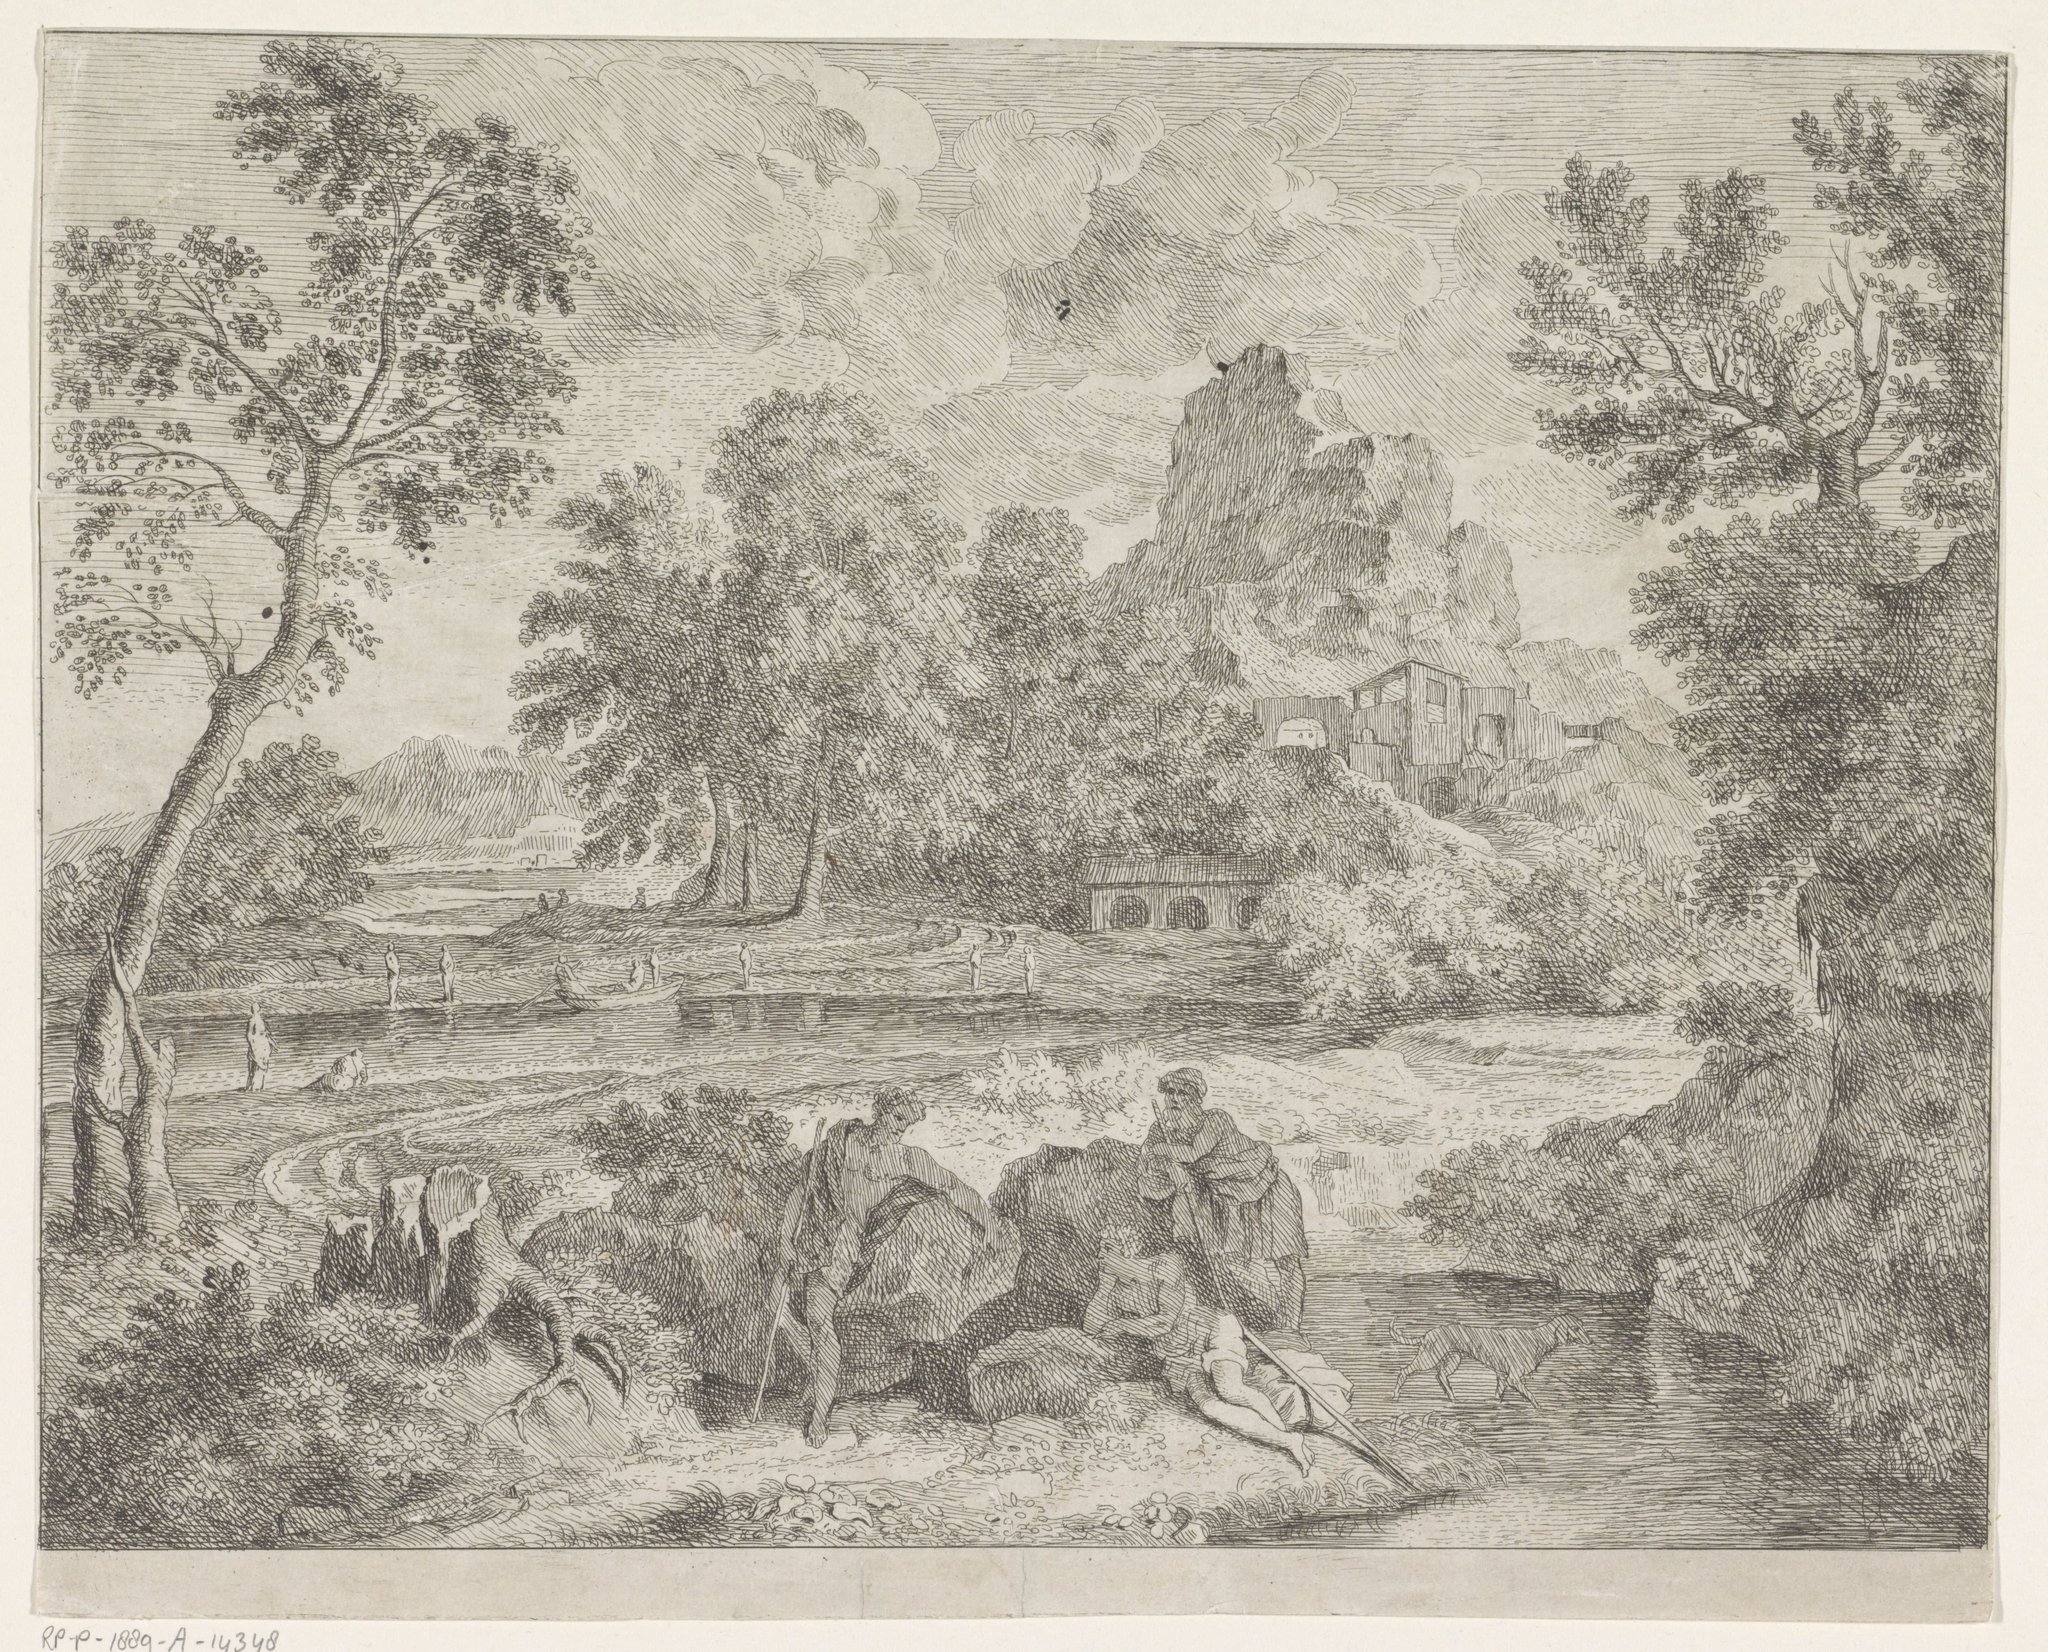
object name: print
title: Arcadisch landschap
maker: Anonymous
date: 1700-1800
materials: paper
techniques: etching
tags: landscapes in the temperate zone, pastorals, arcadian scenes, dog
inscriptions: collector's mark: Lugt 2228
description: Drie rustende herders bij een beek. In het water een hond.